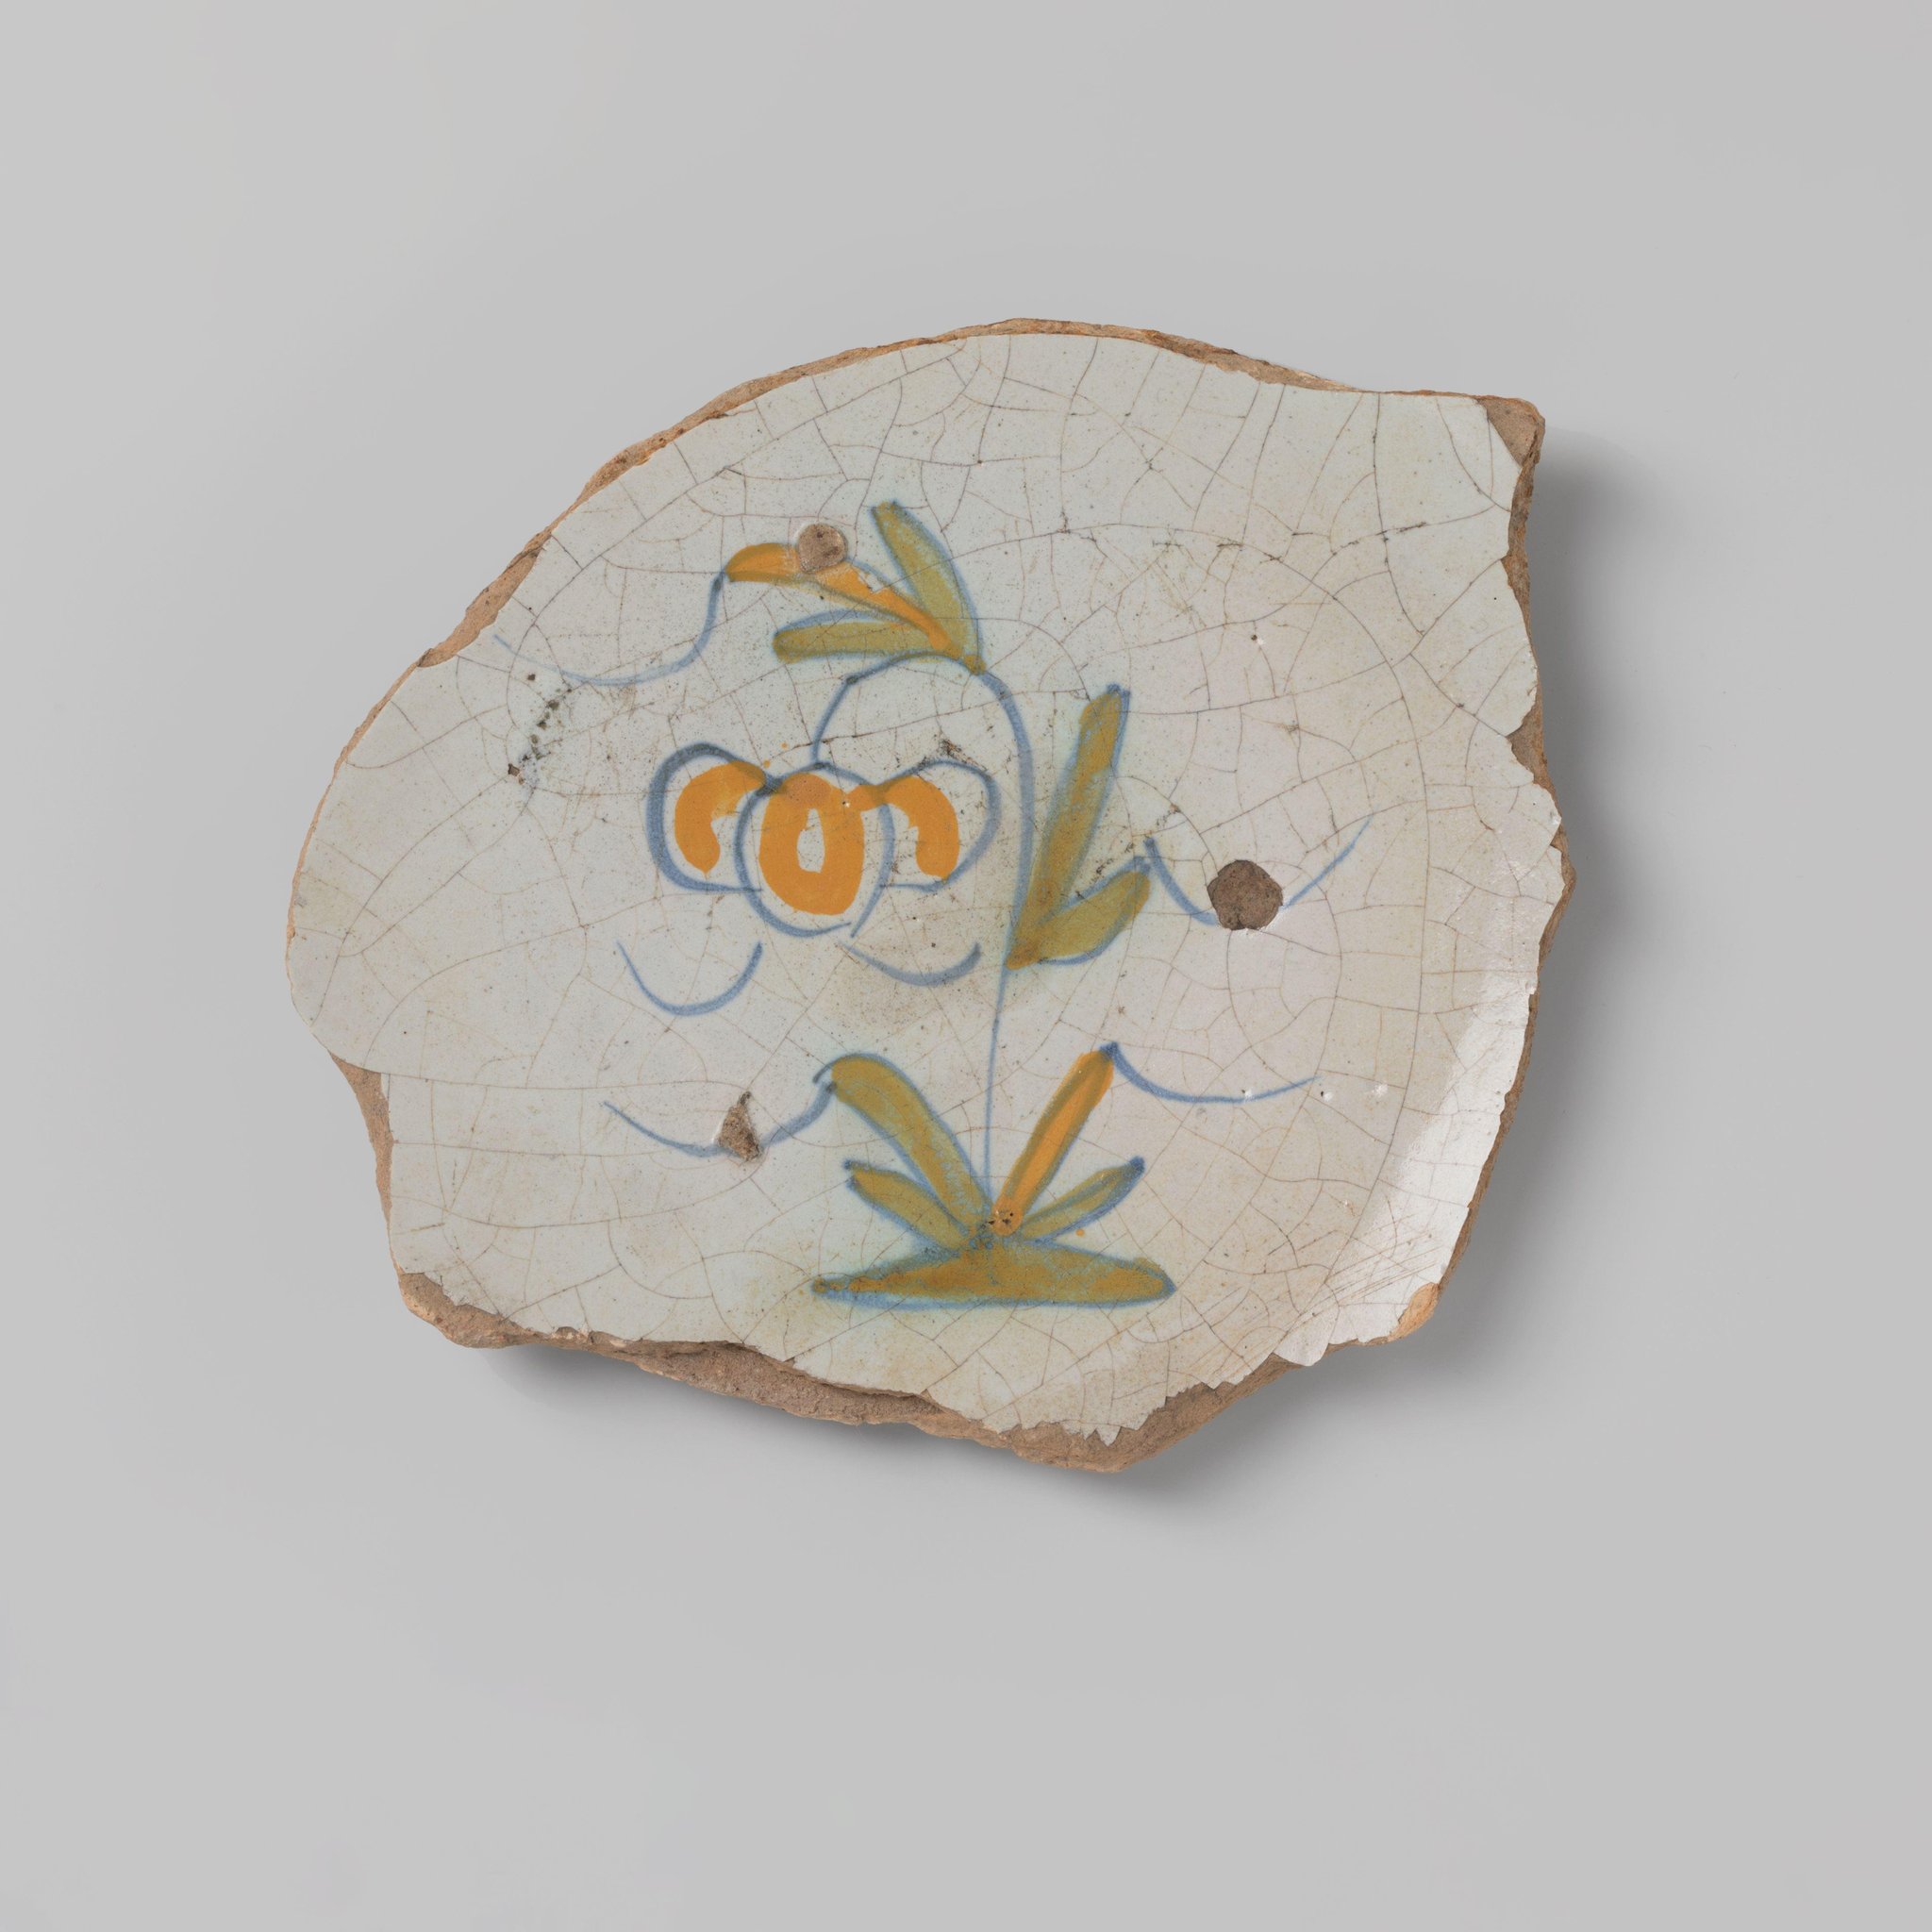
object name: sherd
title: Schotelscherf van aardewerk met veekleurige tekening van een bloem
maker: Anonymous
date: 1500-1799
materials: earthenware, glaze